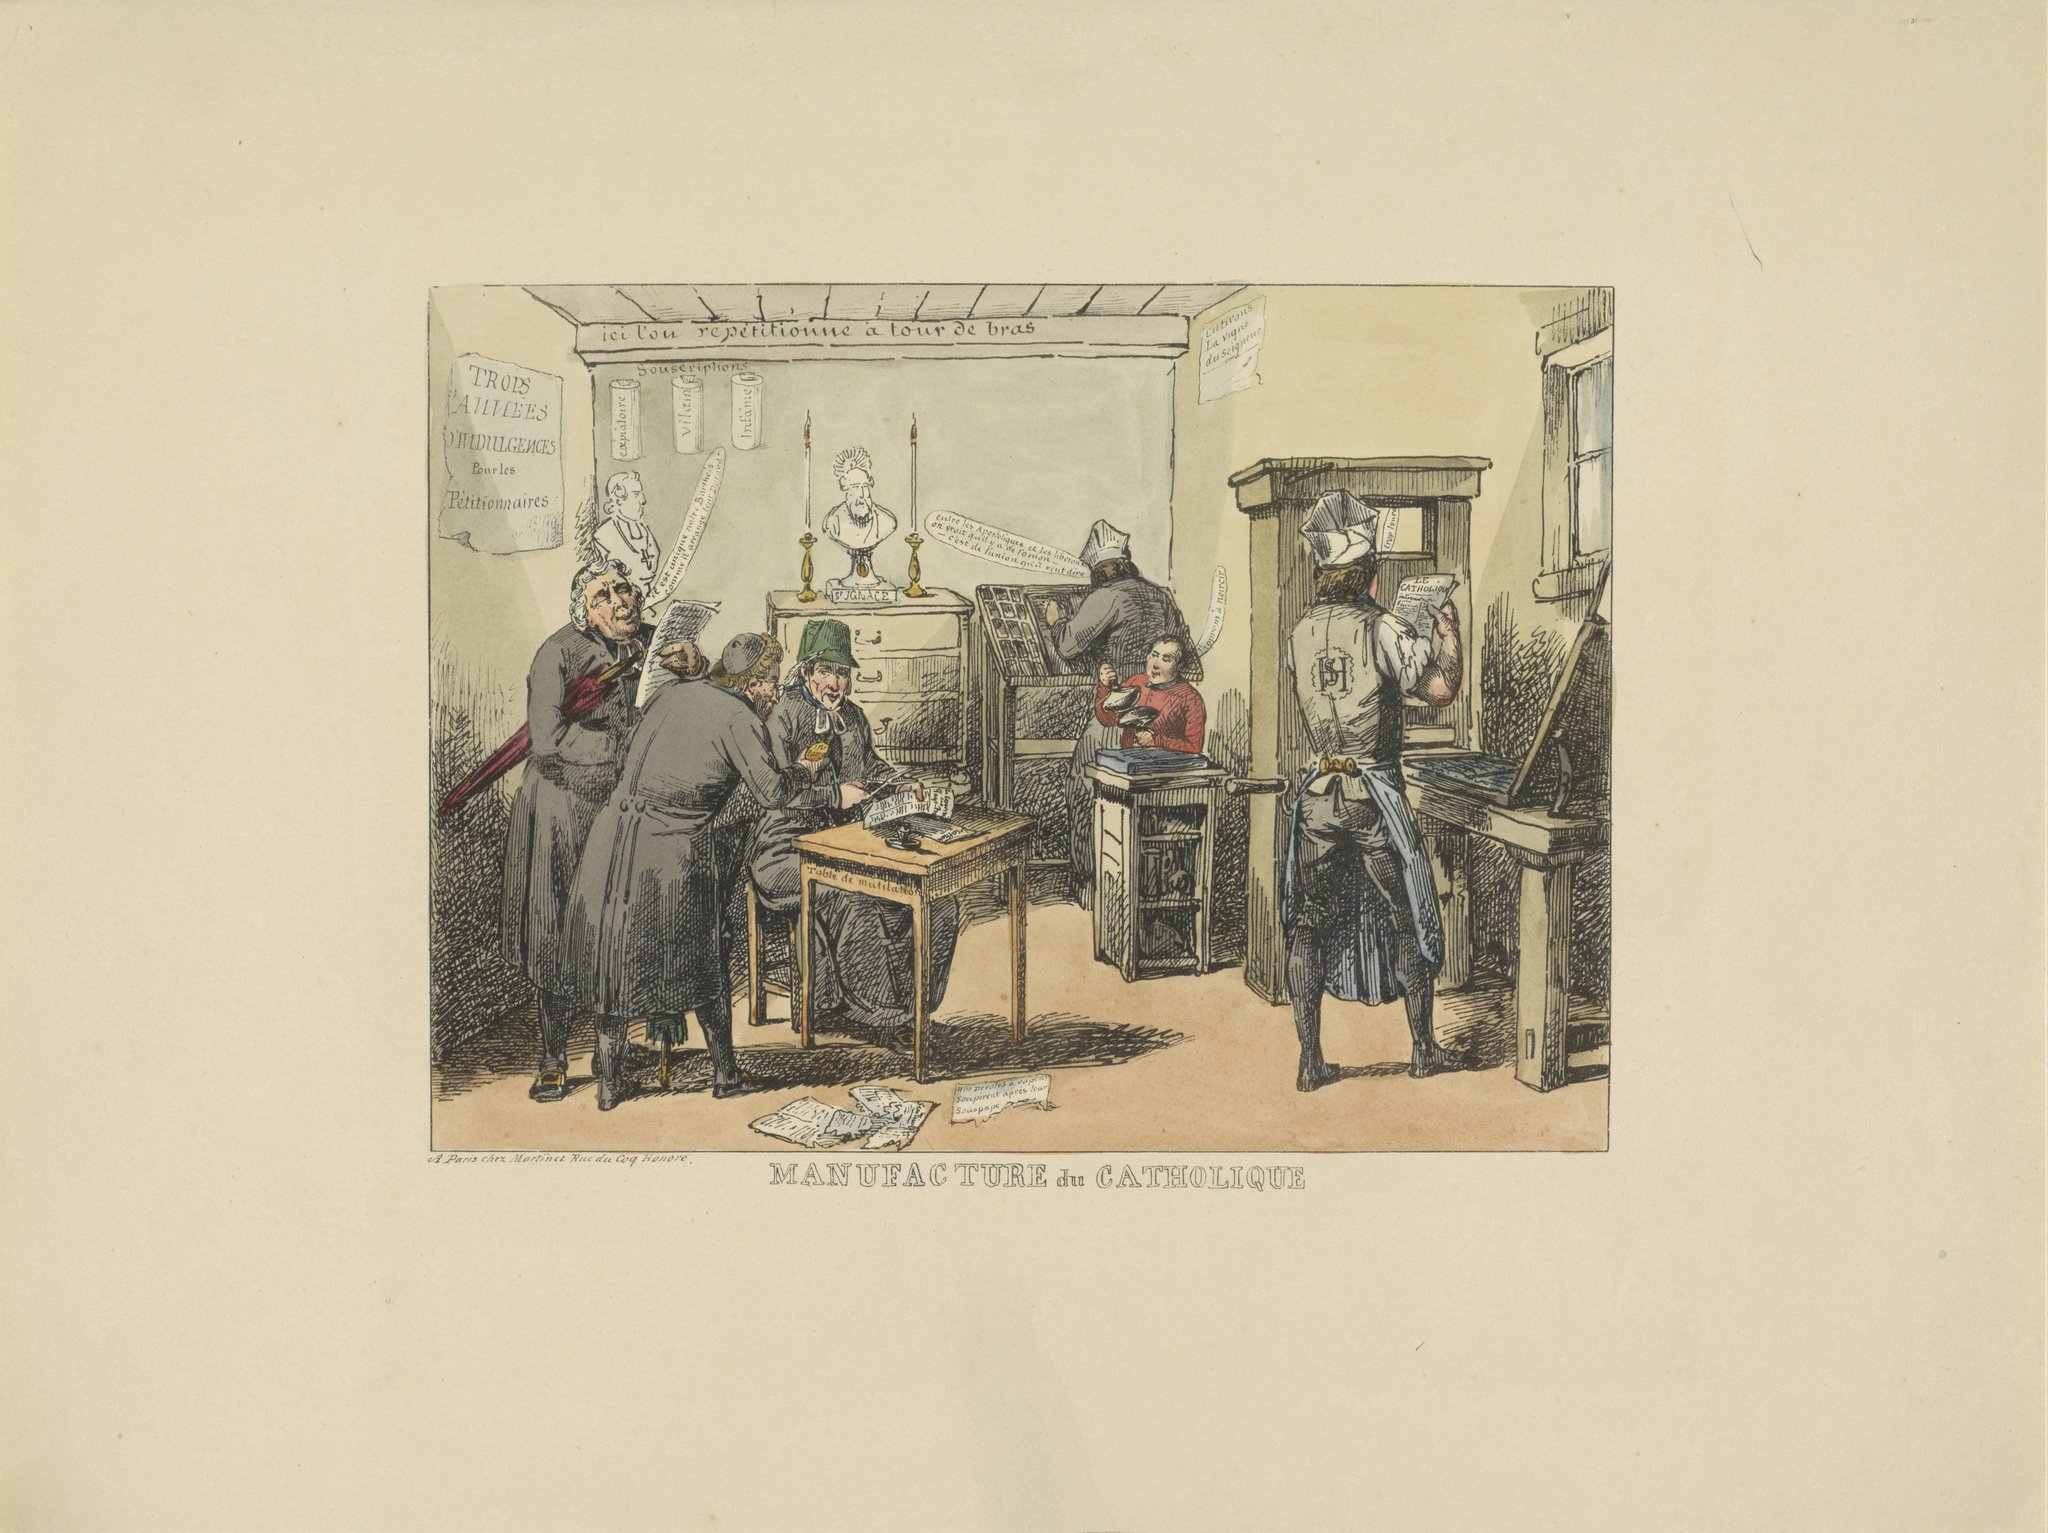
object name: cartoon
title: Spotprent op het blad Le Catholique, 1829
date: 1829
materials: paper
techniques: hand coloring, lithograph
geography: netherlands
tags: regular clerics, e.g. jesuits, redemptorists, persons ~ printing, ghent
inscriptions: collector's mark: Lugt 2228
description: Spotprent op het drukken van het katholieke oppositieblad Le Catholique, 1829. Drukkerij waarin het blad wordt gezet door jezuïeten. Het blad werd in Gent uitgegeven onder redactie van Adolph Barthels.